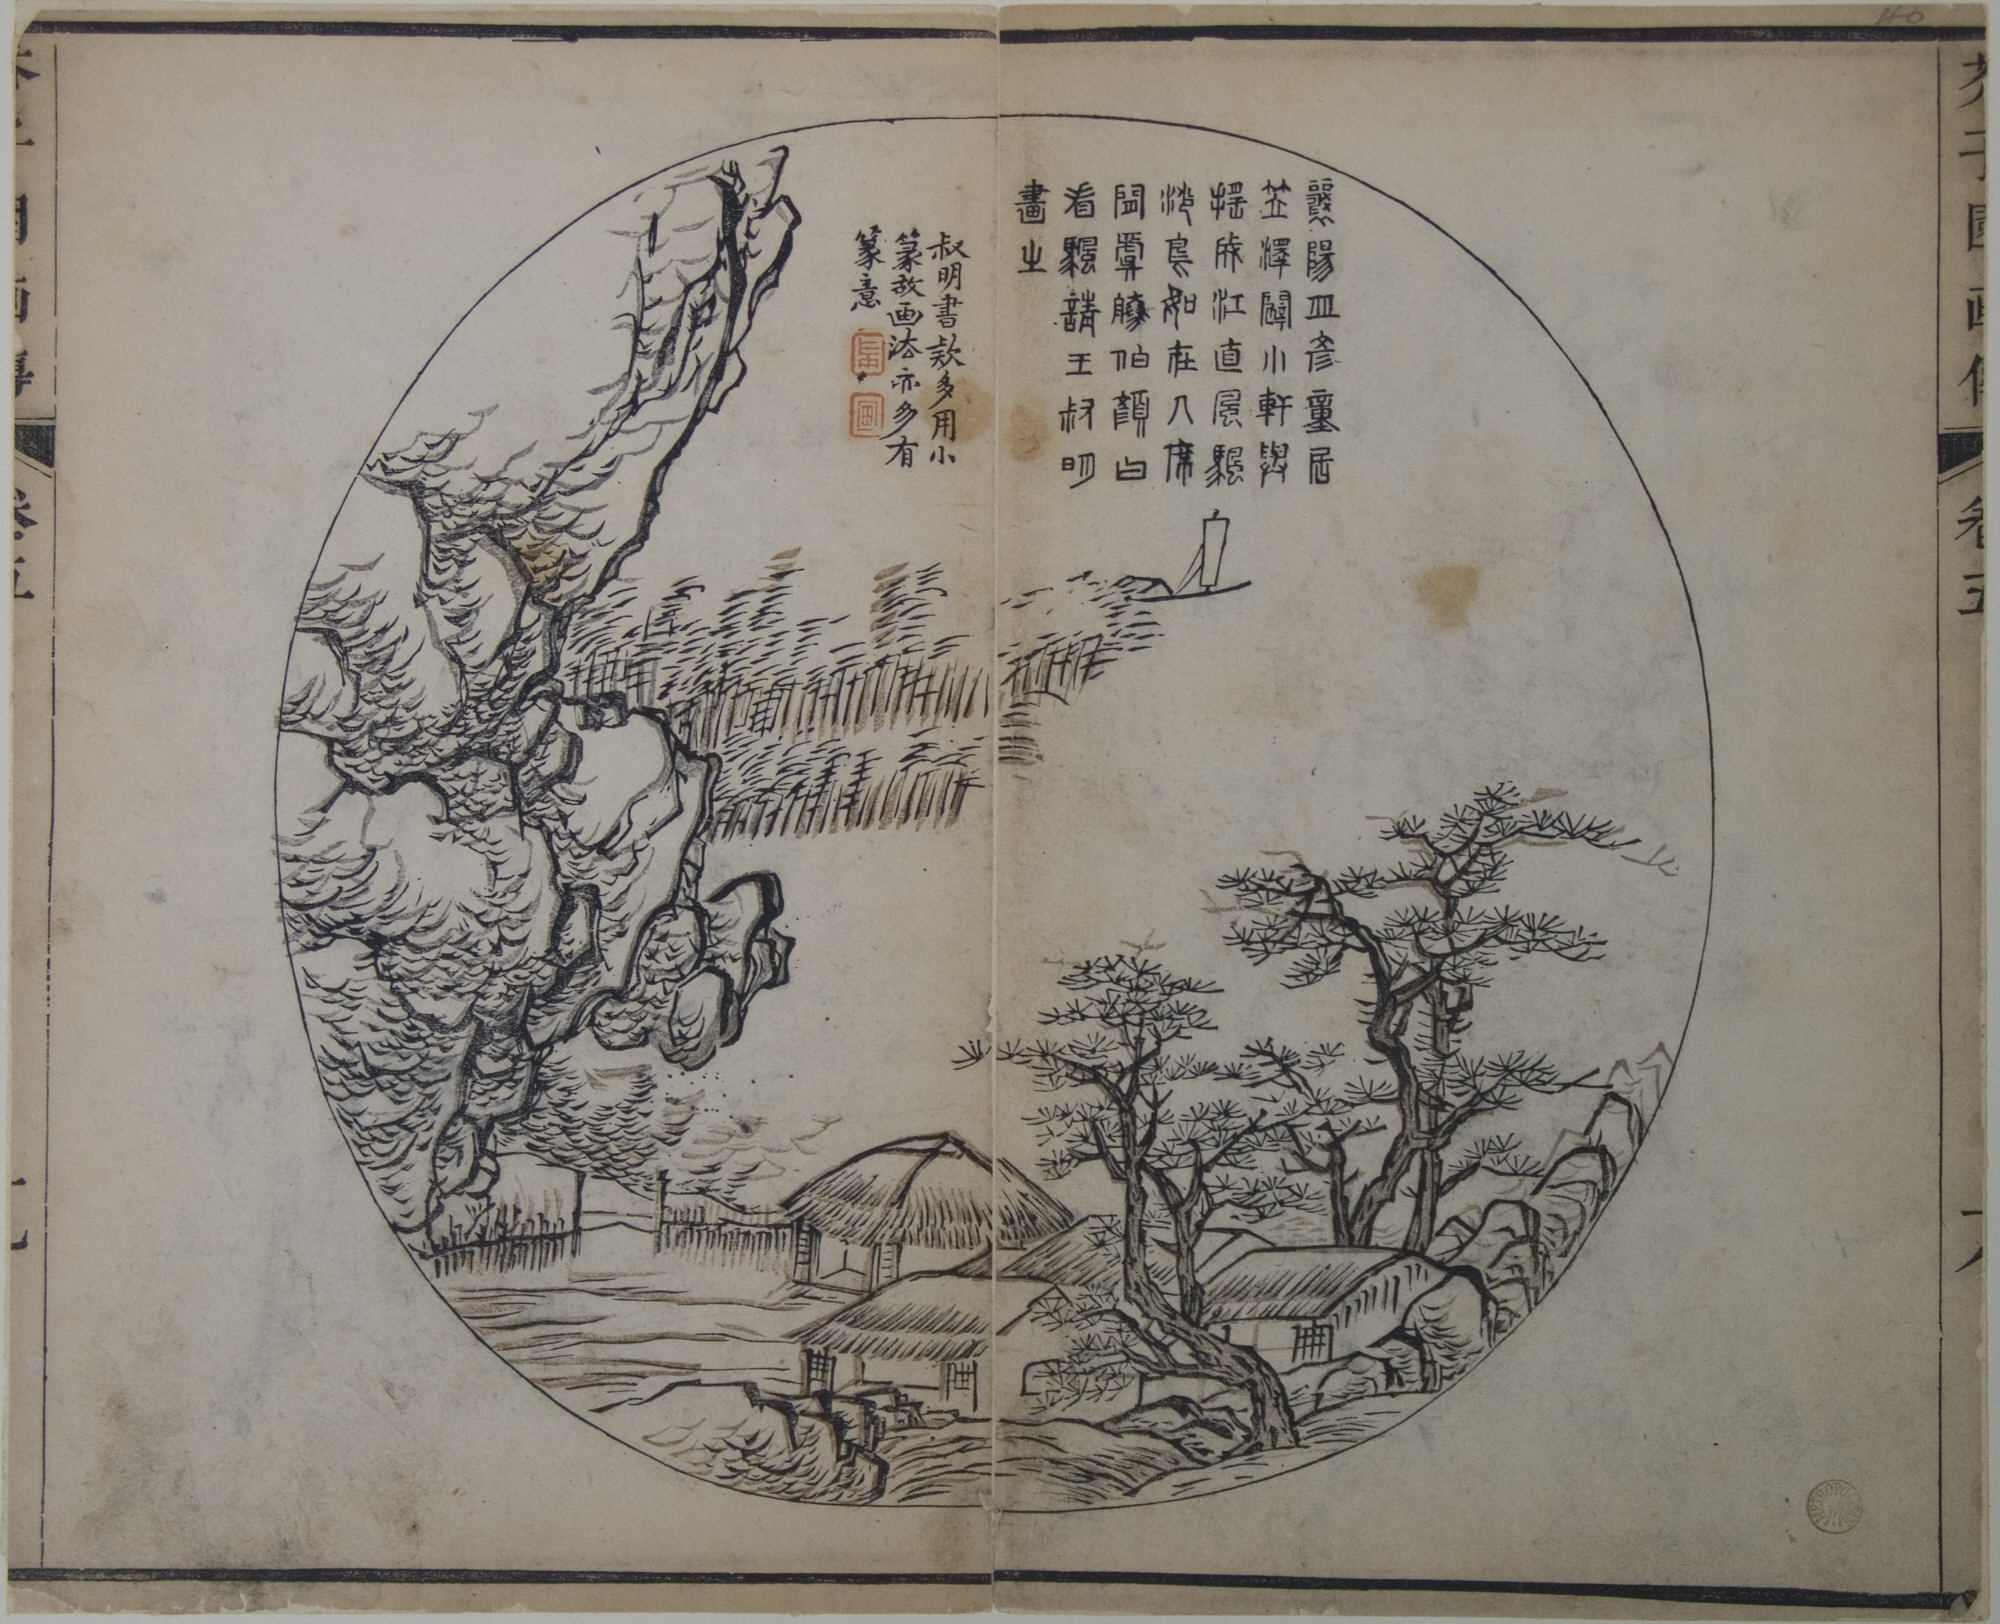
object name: print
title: Page from the Mustard Seed Garden Manual of Painting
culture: chinese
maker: wang gai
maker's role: artist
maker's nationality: chinese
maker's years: 1645-1710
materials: ink, paper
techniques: woodblock print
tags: houses,landscapes,trees